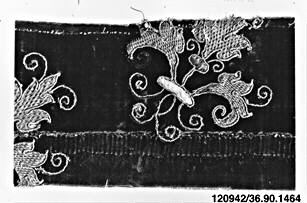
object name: piece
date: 1601-1700